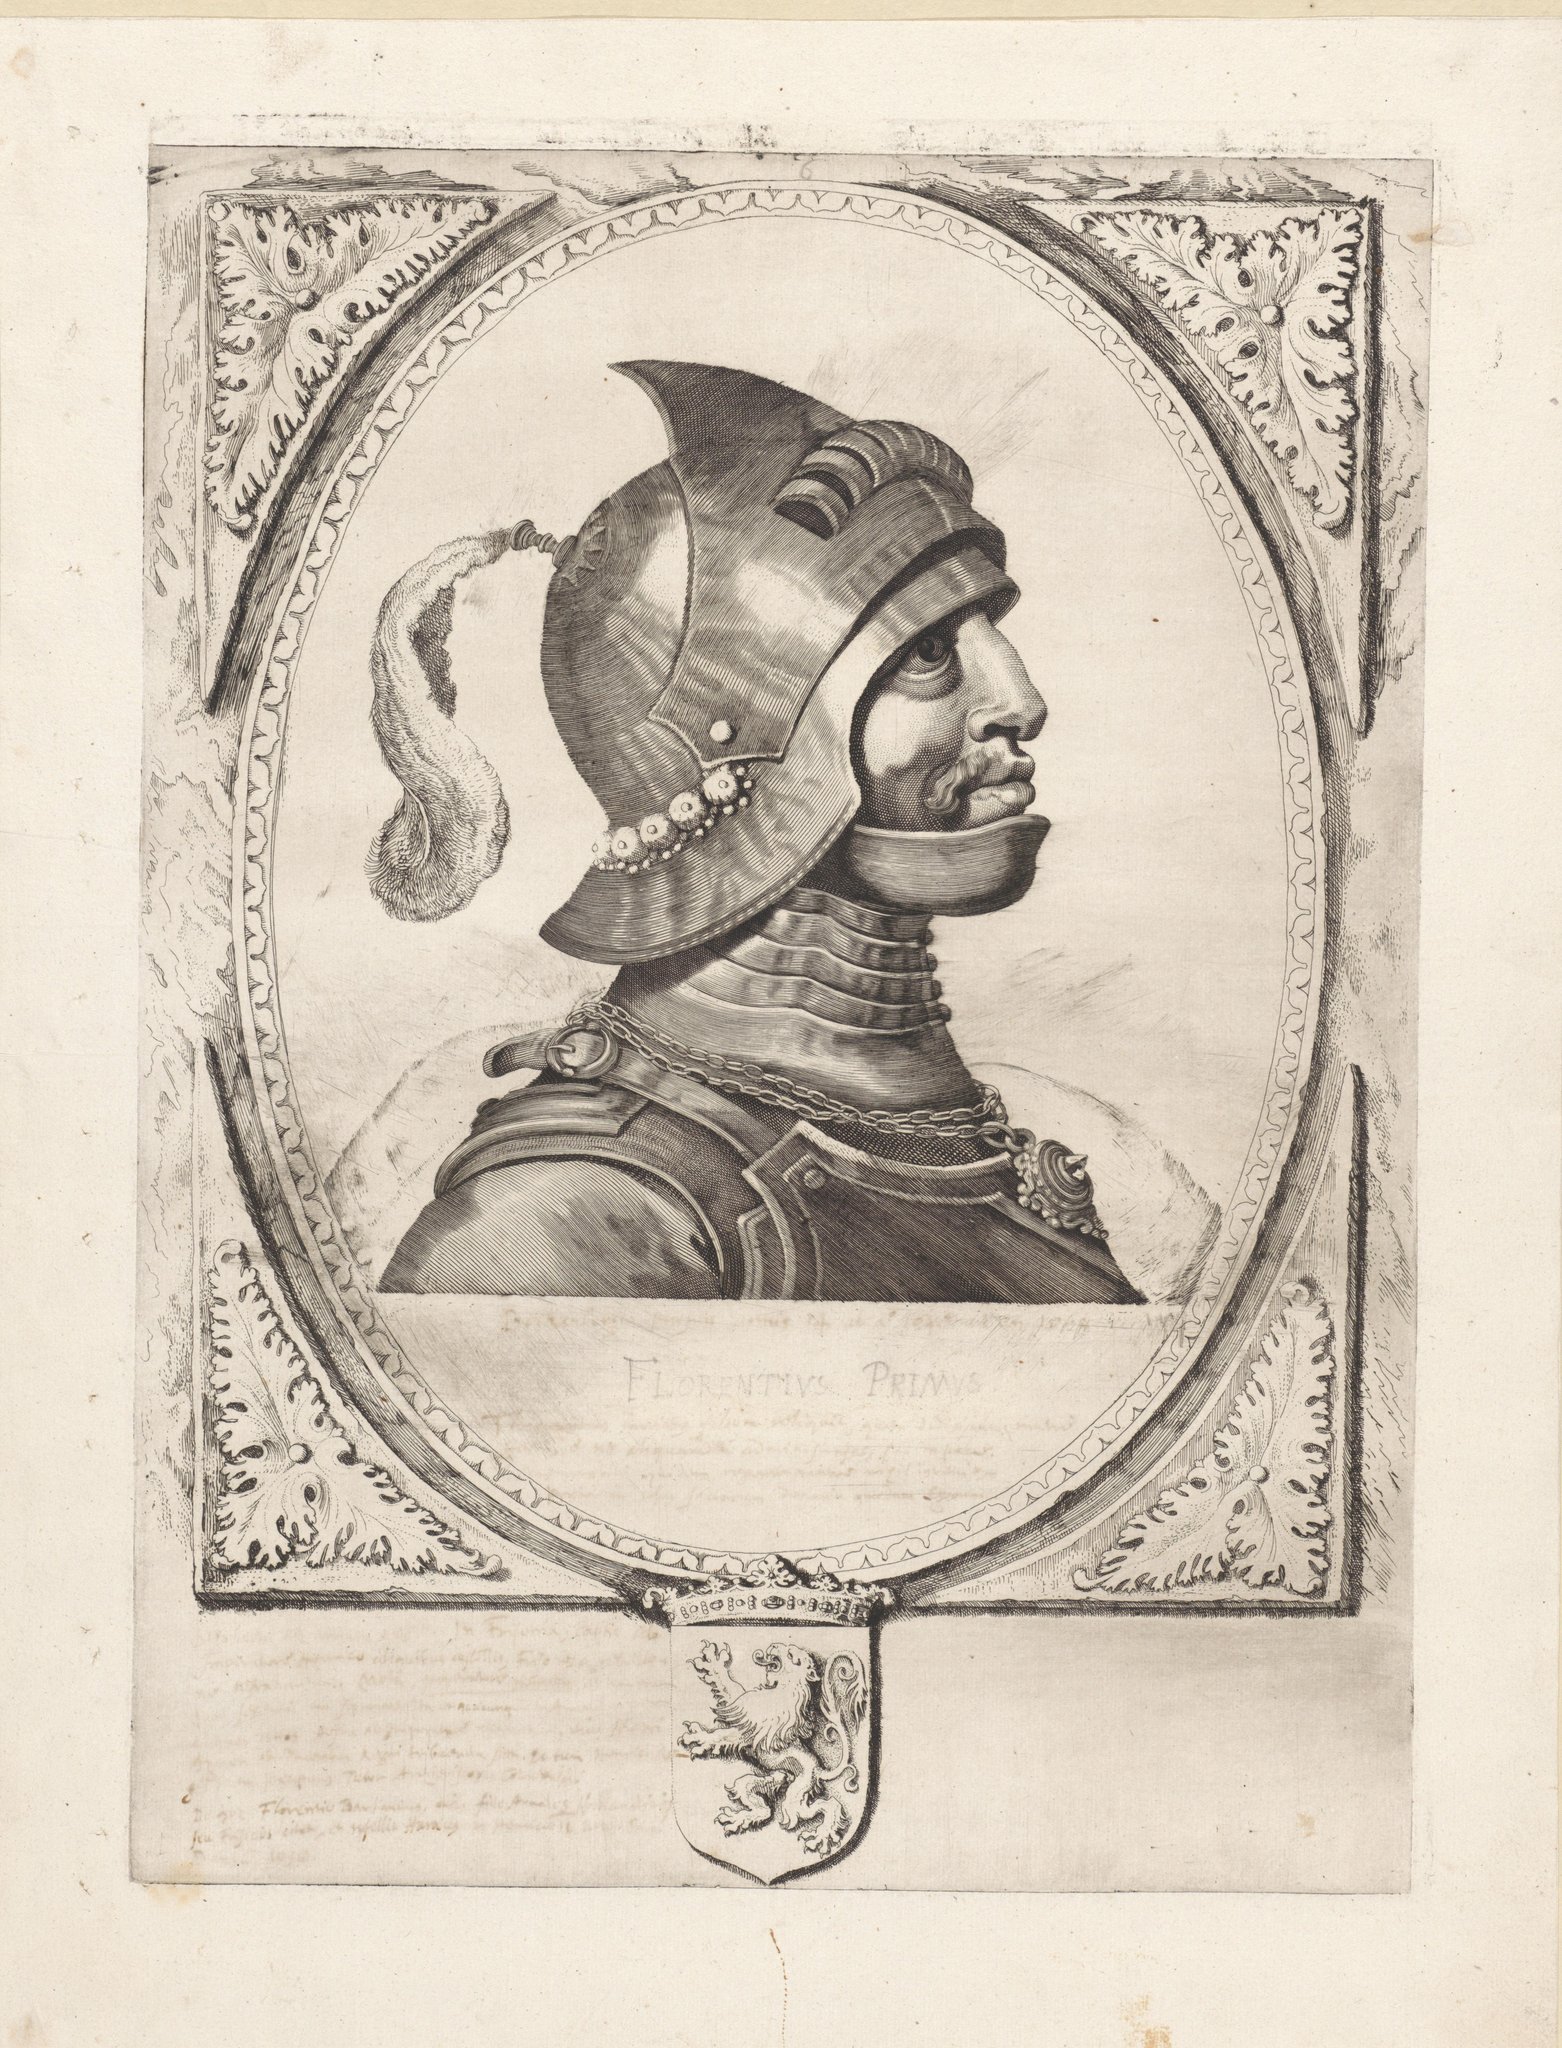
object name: print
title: Portret van Floris I, graaf van Holland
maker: cornelis visscher (ii)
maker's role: draughtsman, painter, print maker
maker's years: 1628-1658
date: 1650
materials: paper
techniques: engraving, etching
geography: haarlem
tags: helmet, armour, nobility and patriciate; chivalry, knighthood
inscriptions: collector's mark: Lugt 240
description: Proefdruk van de zesde prent uit de serie 'Graven en gravinnen van Holland, Zeeland en West-Friesland', bestaande uit 38 prenten.